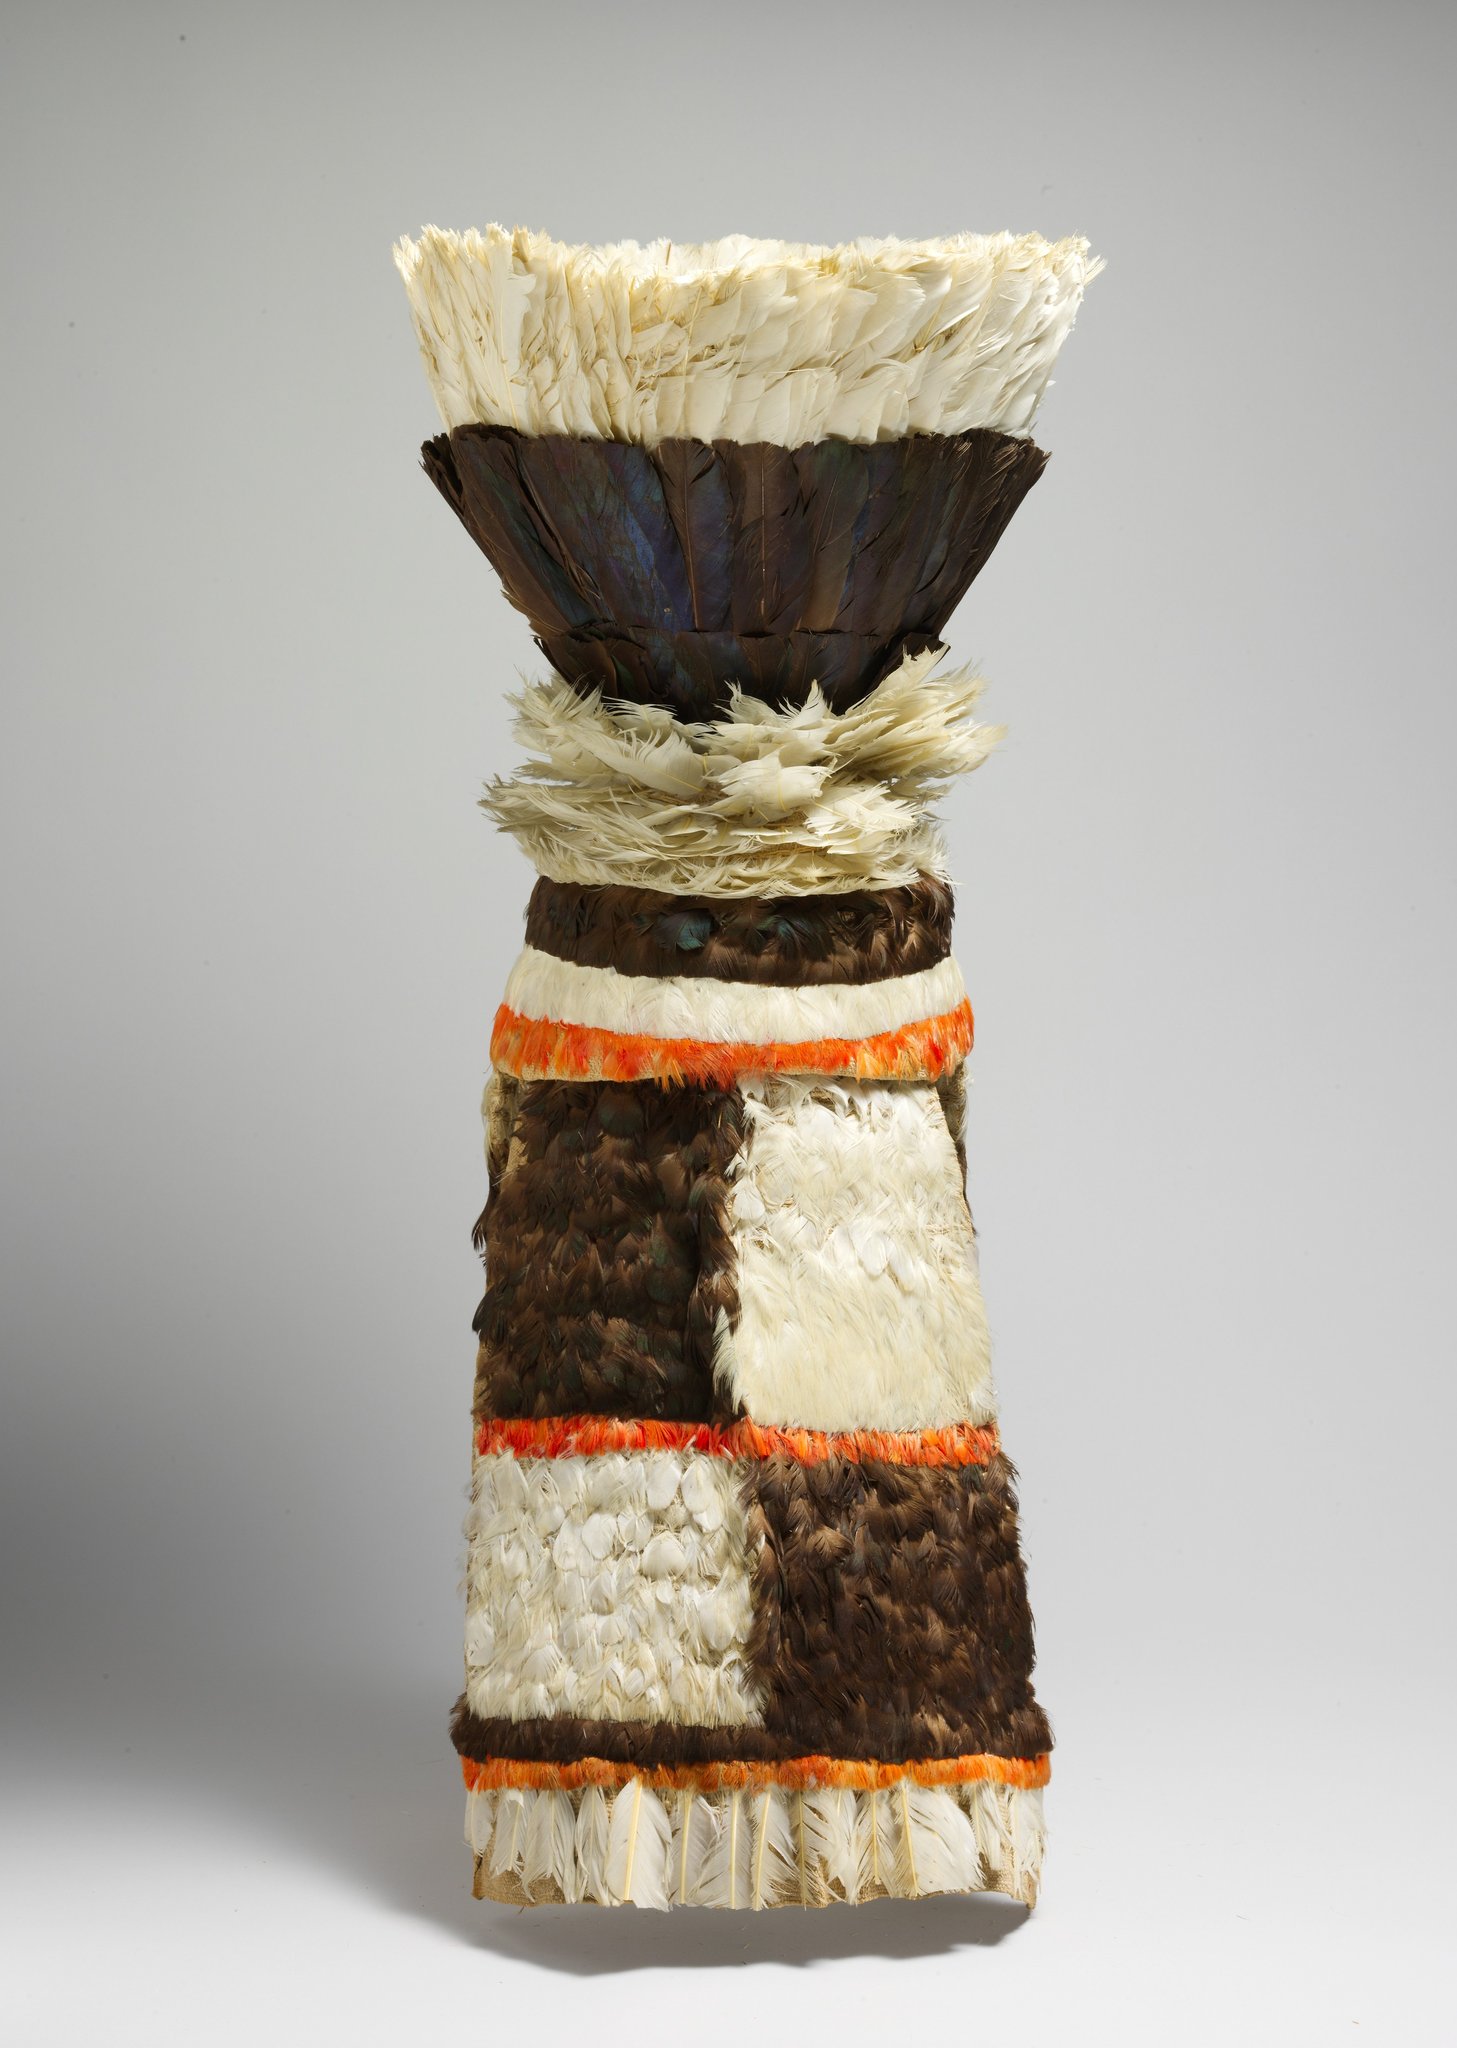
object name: headdress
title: Feathered Headdress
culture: chimú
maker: chimú artist(s)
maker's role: artist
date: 1401-1633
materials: cotton, feather, fiber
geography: peru